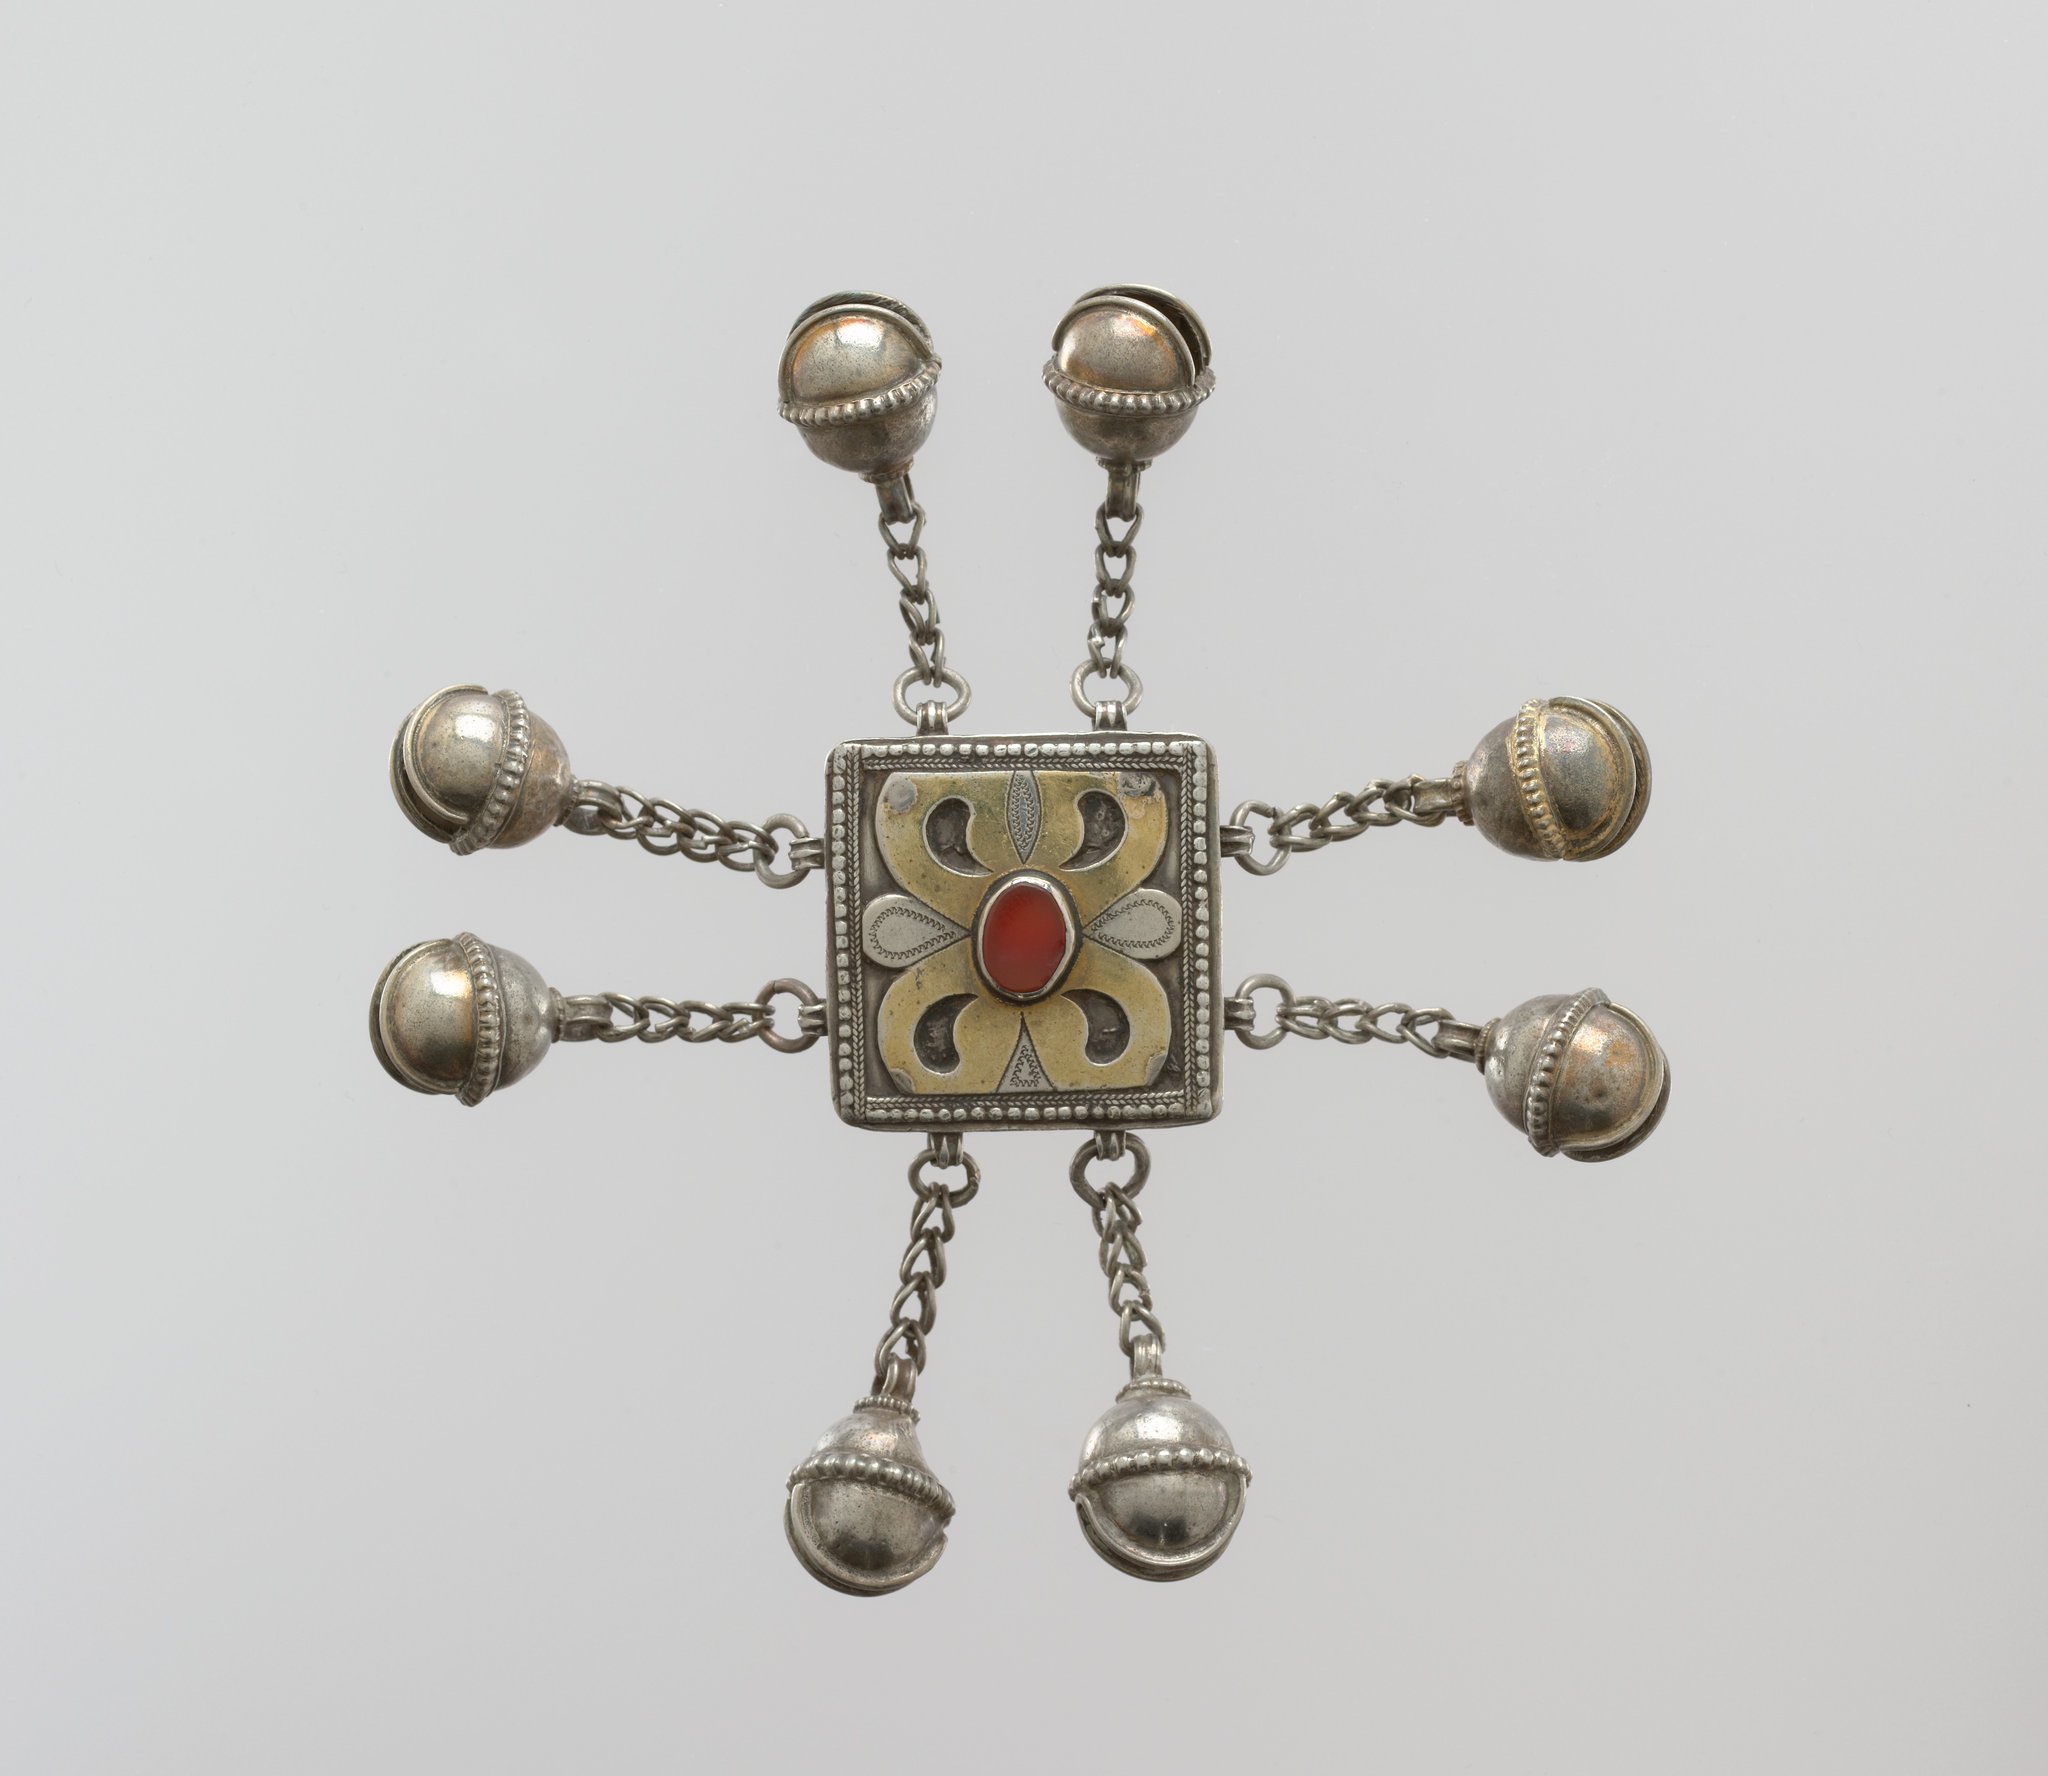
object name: necklace, bead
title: Amulet for Boy's Cap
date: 1867-1933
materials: gemstone, silver, metal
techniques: chasing, cutting, gilding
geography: central asia